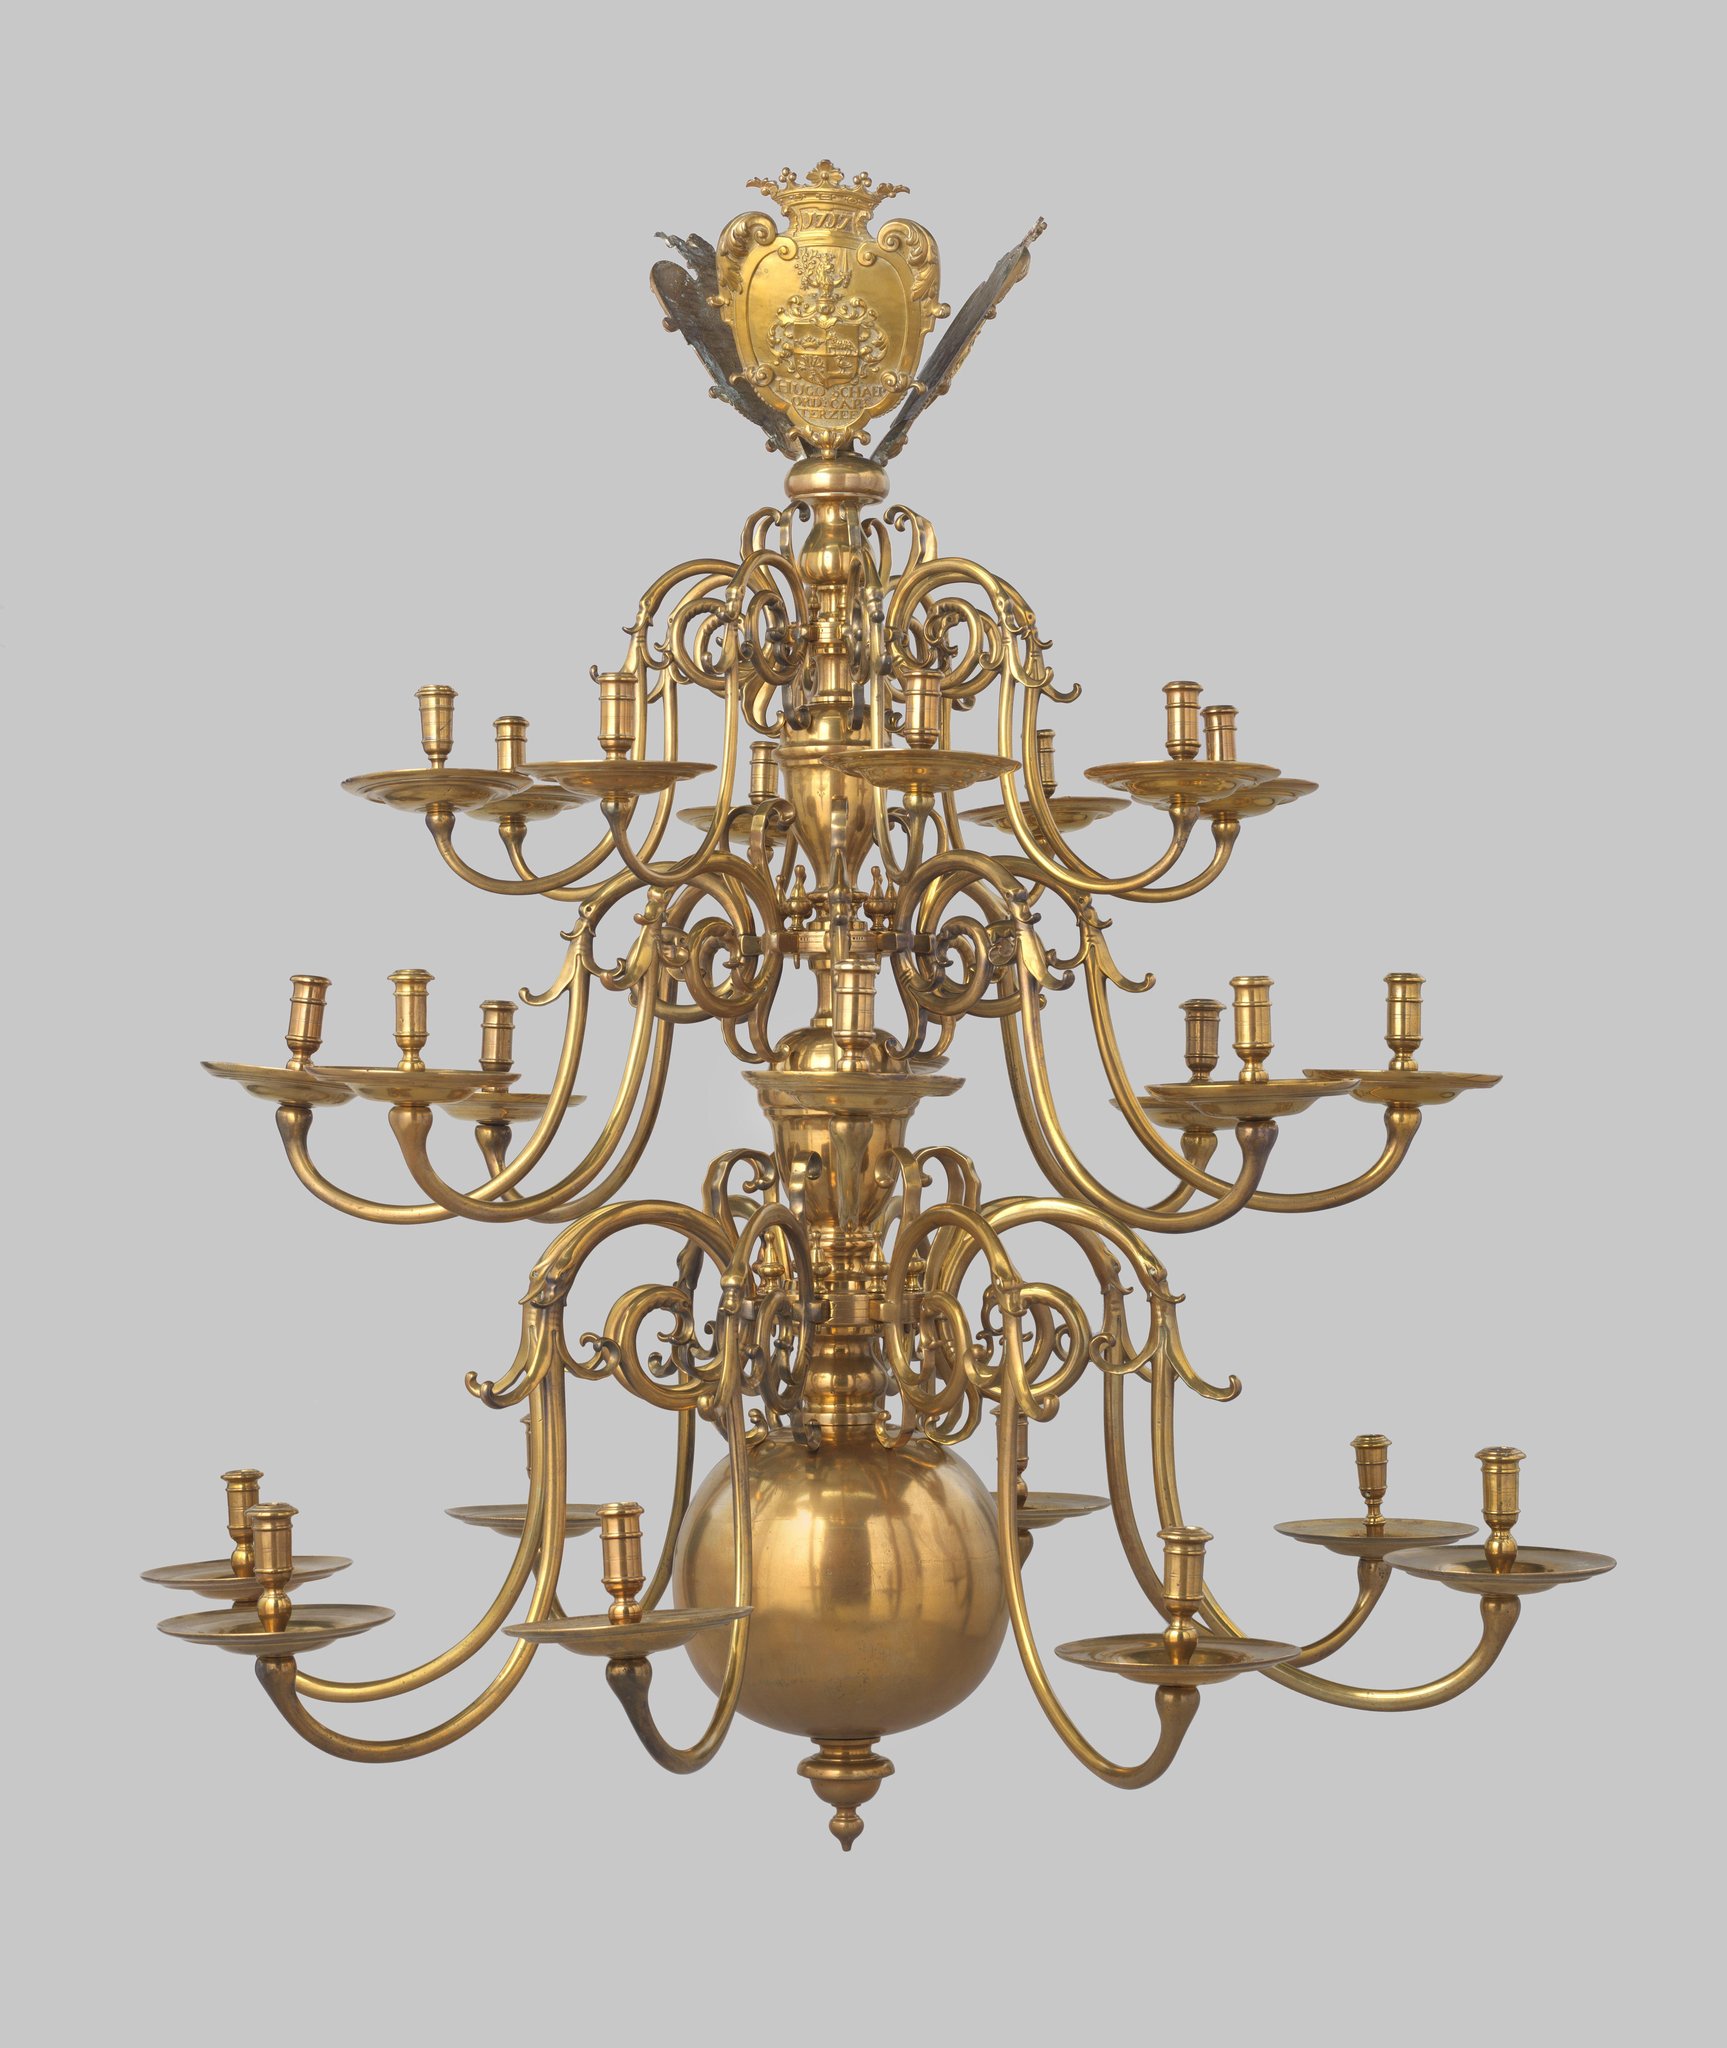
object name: chandelier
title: Arm van een kaarsenkroon in drie hoogten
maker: Anonymous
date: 1717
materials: brass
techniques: casting, screwed, turning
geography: amsterdam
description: De S-vormige arm is aan de stamzijde voorzien van een nok om deze met een pin in de standring te kunnen vastzetten. Bij de stam is de arm op het eind en naar het midden toe versierd met twee gestileerde dolfijnenkoppen en met krullen, waarvan de vorm aan het kwabornament is ontleend. Naar buiten toe eindigt de arm in een verdikking, waarin een van een schroefdraad voorzien gat is aangebracht ter bevestiging van de kaarsenhouder op de vetvanger. De arm is met behulp van hetzelfde model gegoten als de overige armen van de krans. De kaarsenhouder is cylindervormig met geprofileerd uitstekende rand en met een balustervoet, welke overgaat in een van een schroefdraad voorzien eind, waarin onderaan het centergat. De vetvanger is aan de bovenkant naar het midden toe twee keer verdiept. Aan de onderkant is deze rond het gat in het enigszins bolvormige midden geprofileerd en is de rand geribd. De vetvanger met behulp van hetzelfde model gegoten als de overige vetvangers van deze krans. De pin is voorzien van een vaasvormige knop. Dit is de zevende arm van de bovenste standring, genummerd op de nok met het cijfer VII.